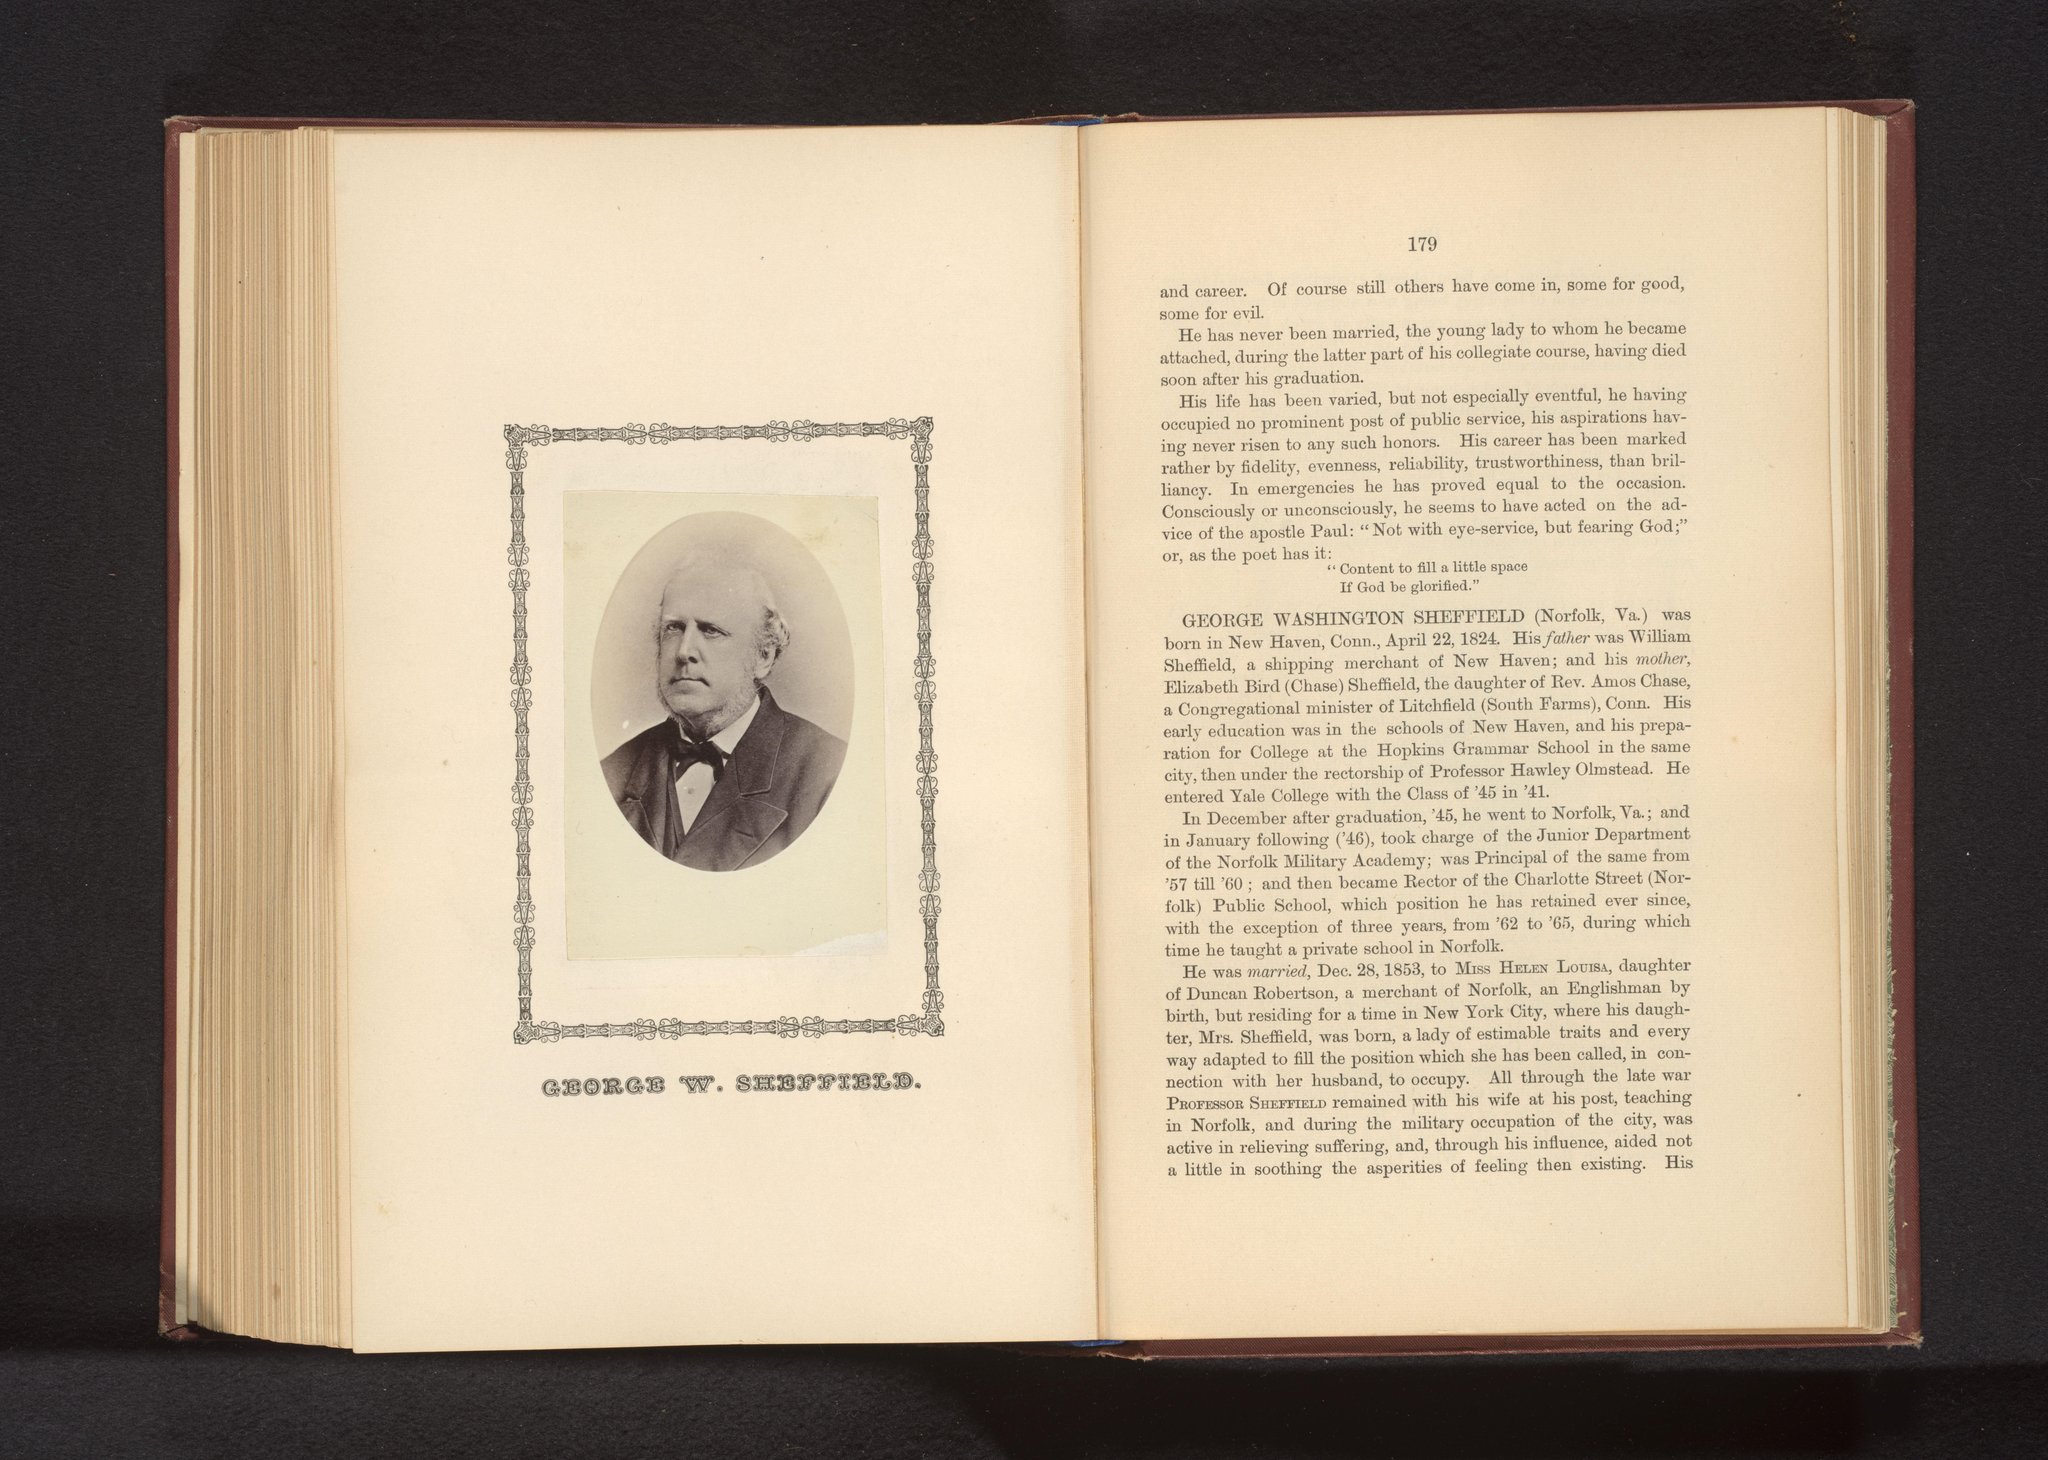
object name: page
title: George W. Sheffield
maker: Anonymous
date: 1876-1881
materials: photographic support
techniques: albumen print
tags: adult man